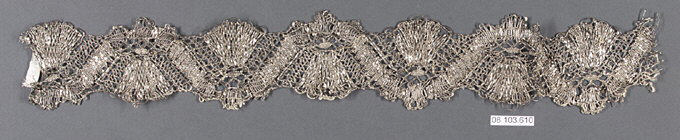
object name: piece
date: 1701-1800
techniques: lace